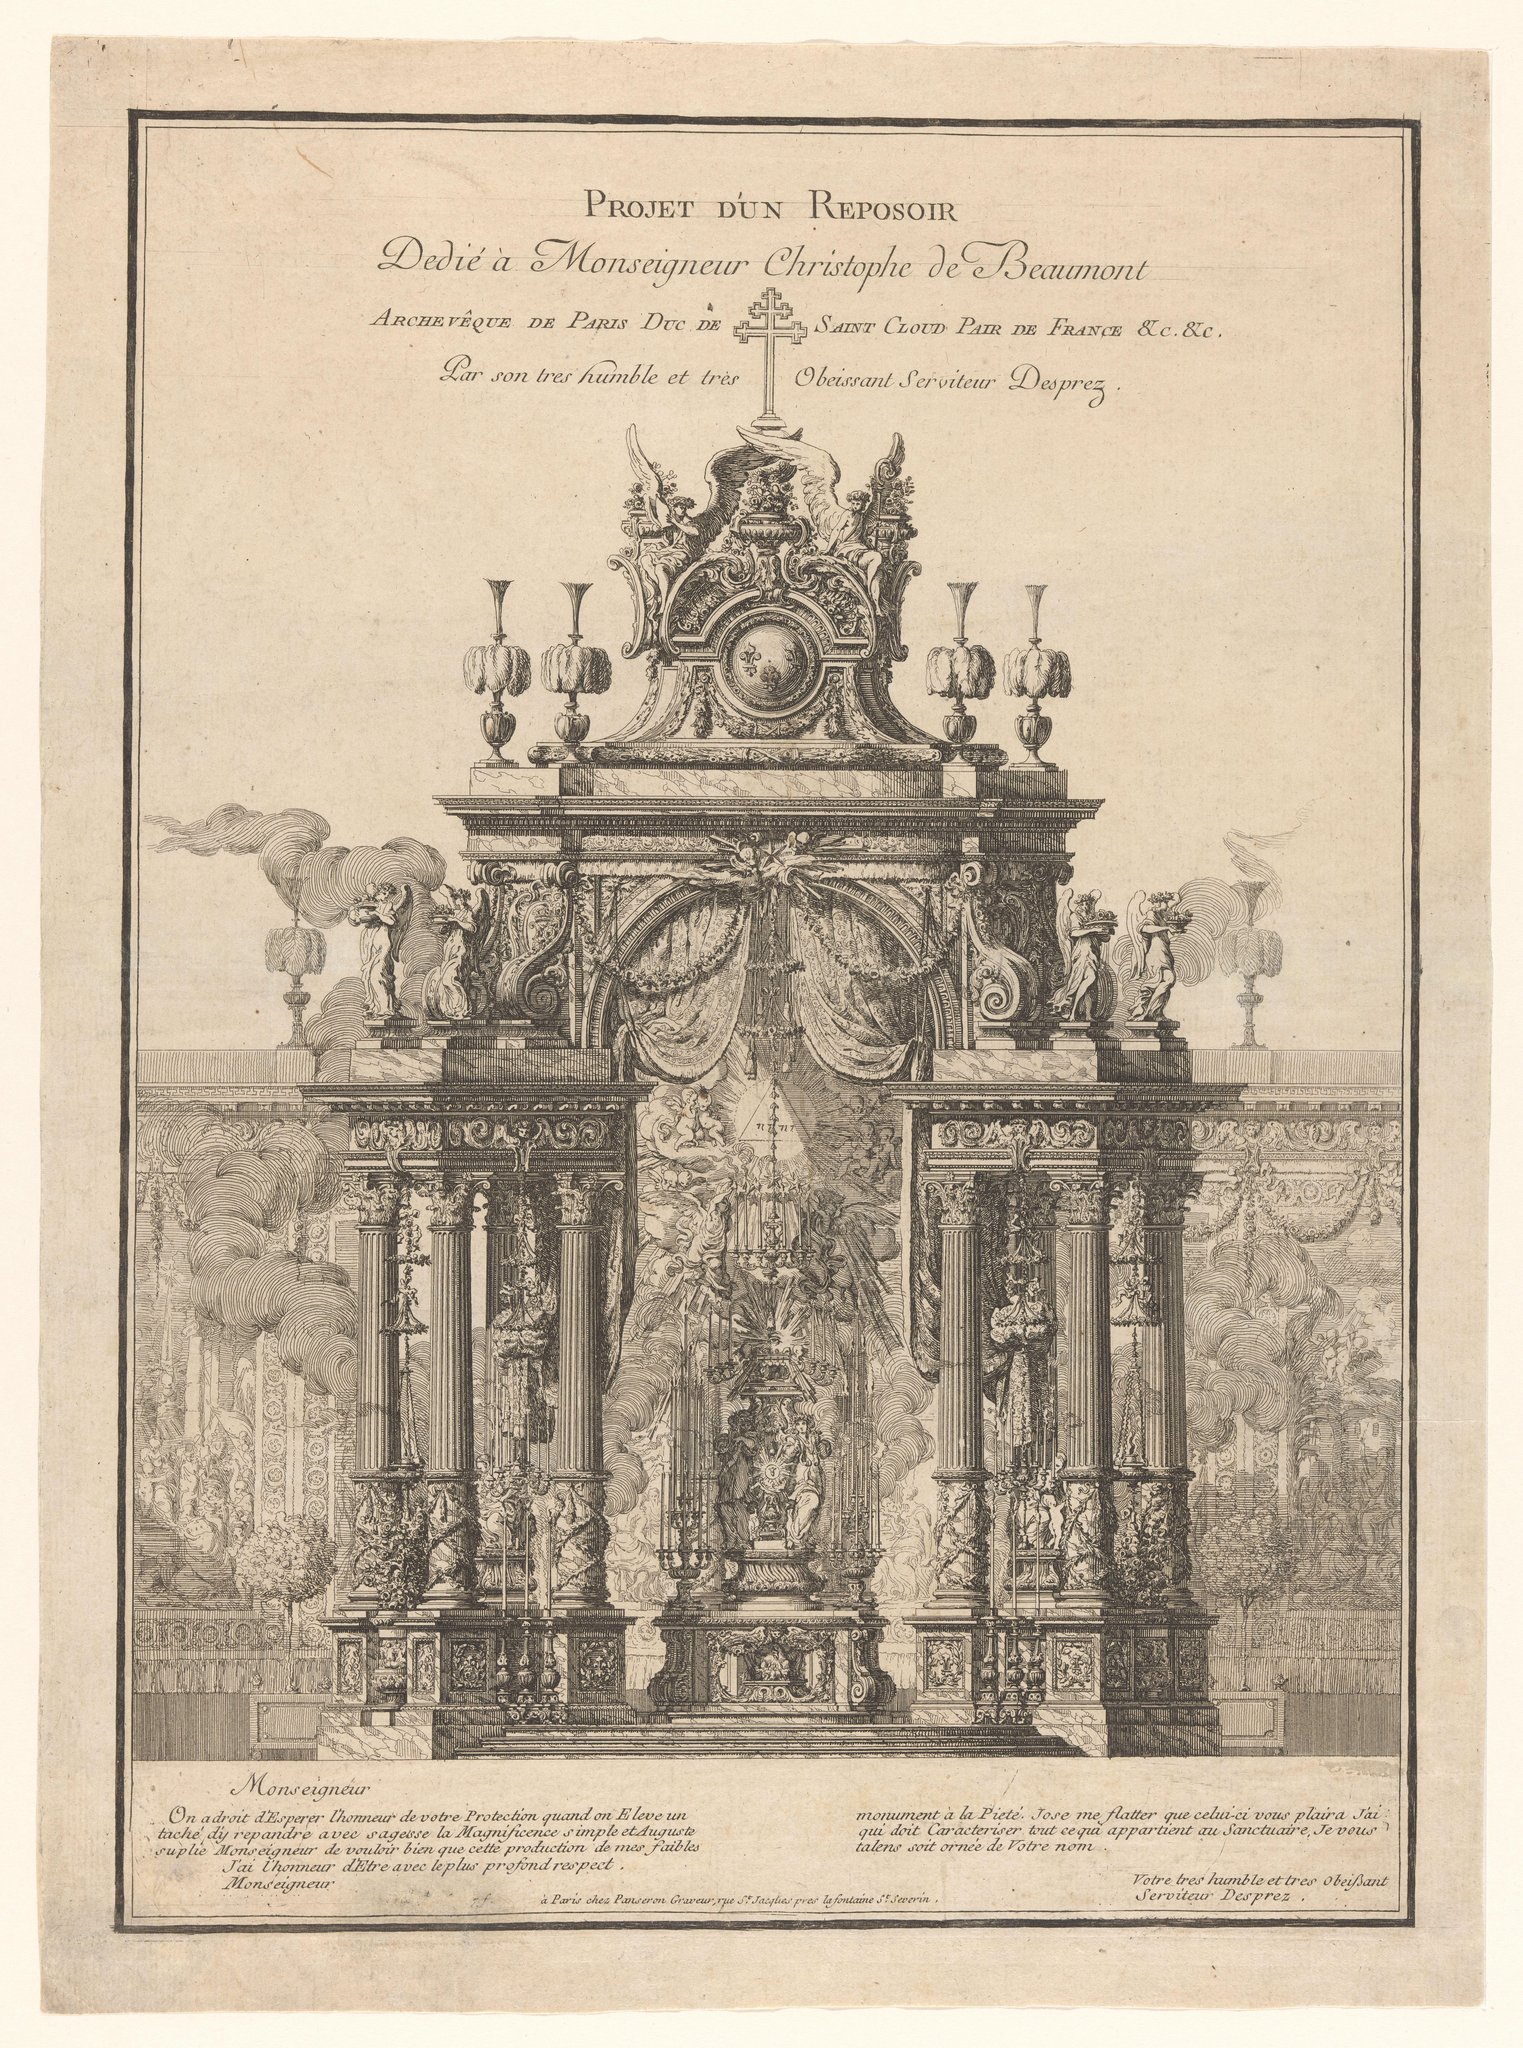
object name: print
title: Ontwerp voor een baldakijn ter decoratie van een altaar, op te richten tijdens de Heilige week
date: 1769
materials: paper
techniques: etching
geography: paris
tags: (liturgical) equipment of church, altar under altar-canopy or ciborium, other feasts of the ecclesiastical year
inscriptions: collector's mark: Lugt 2228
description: Ontwerp voor een baldakijn ter decoratie van een altaar gedurende de Heilige week. De constructie is voorzien van Franse lelies en het pauselijk kruis. De prent is opgedragen aan Christophe de Beaumont, aartsbisschop van Parijs (van 1746 tot 1781). Met dit complexe voorbeeld van zijn vroege prentkunst won Desprez in 1770 de grote prijs van de Academie d’Architecture. De ets maakt oorspronkelijk deel uit van een serie van zes met details en een plattegrond van het ontwerp.